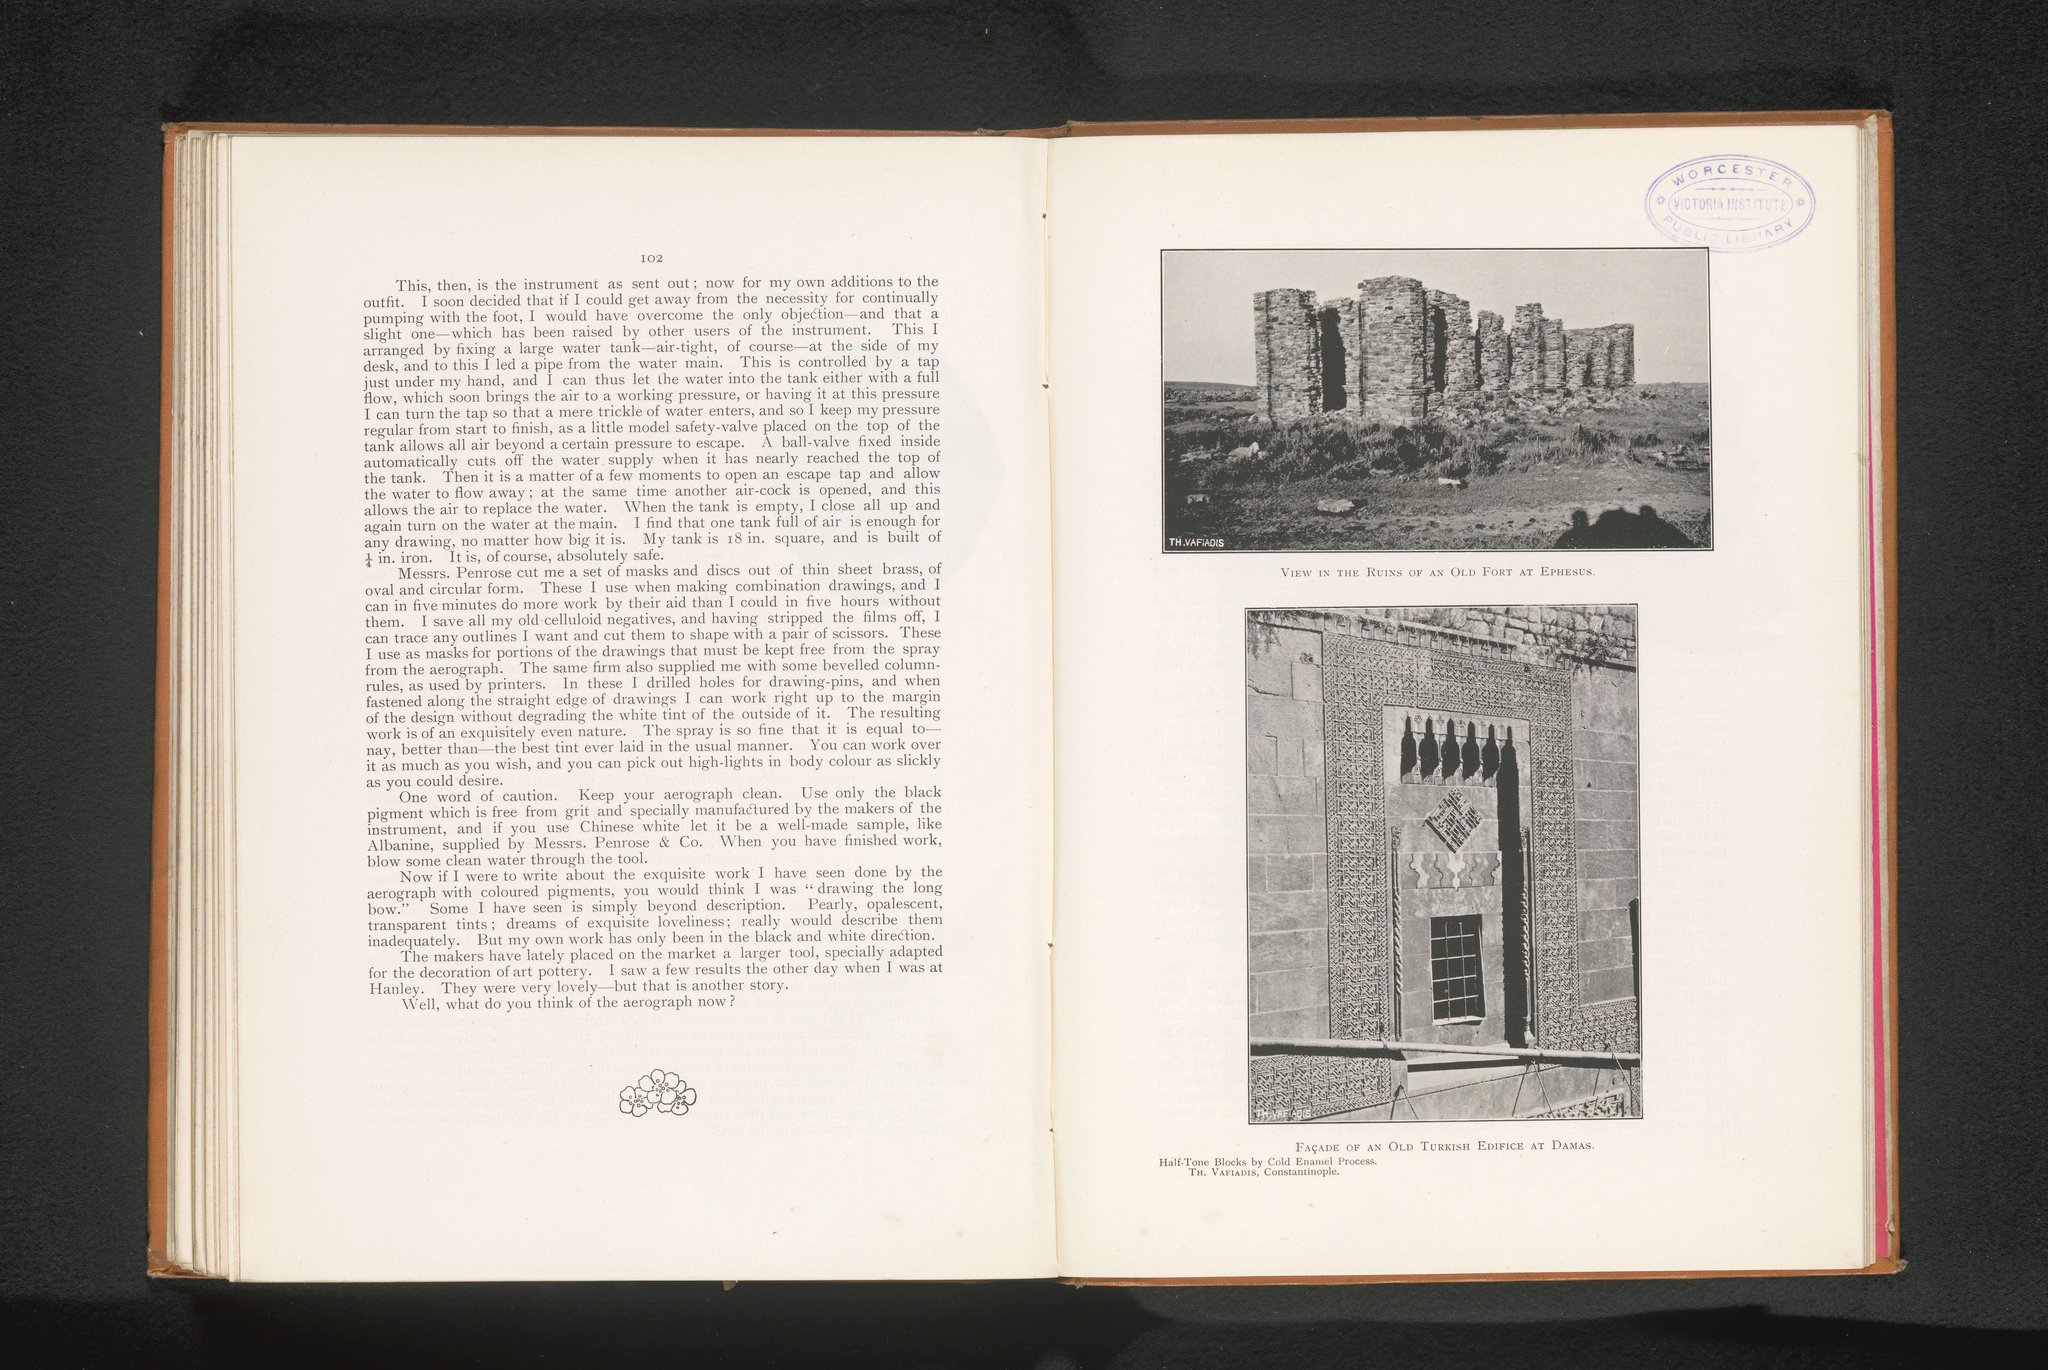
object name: photomechanical print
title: Gezicht op een ruïne in Efeze en de façade van een gebouw in Turkse stijl te Damascus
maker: theodore vafiadis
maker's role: clichémaker, fotograaf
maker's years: -1922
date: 1894-1899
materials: paper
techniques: autotype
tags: landscape with ruins, façade (of house or building)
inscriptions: collector's mark: ‘Worcester Public Library/ Victoria Institute’